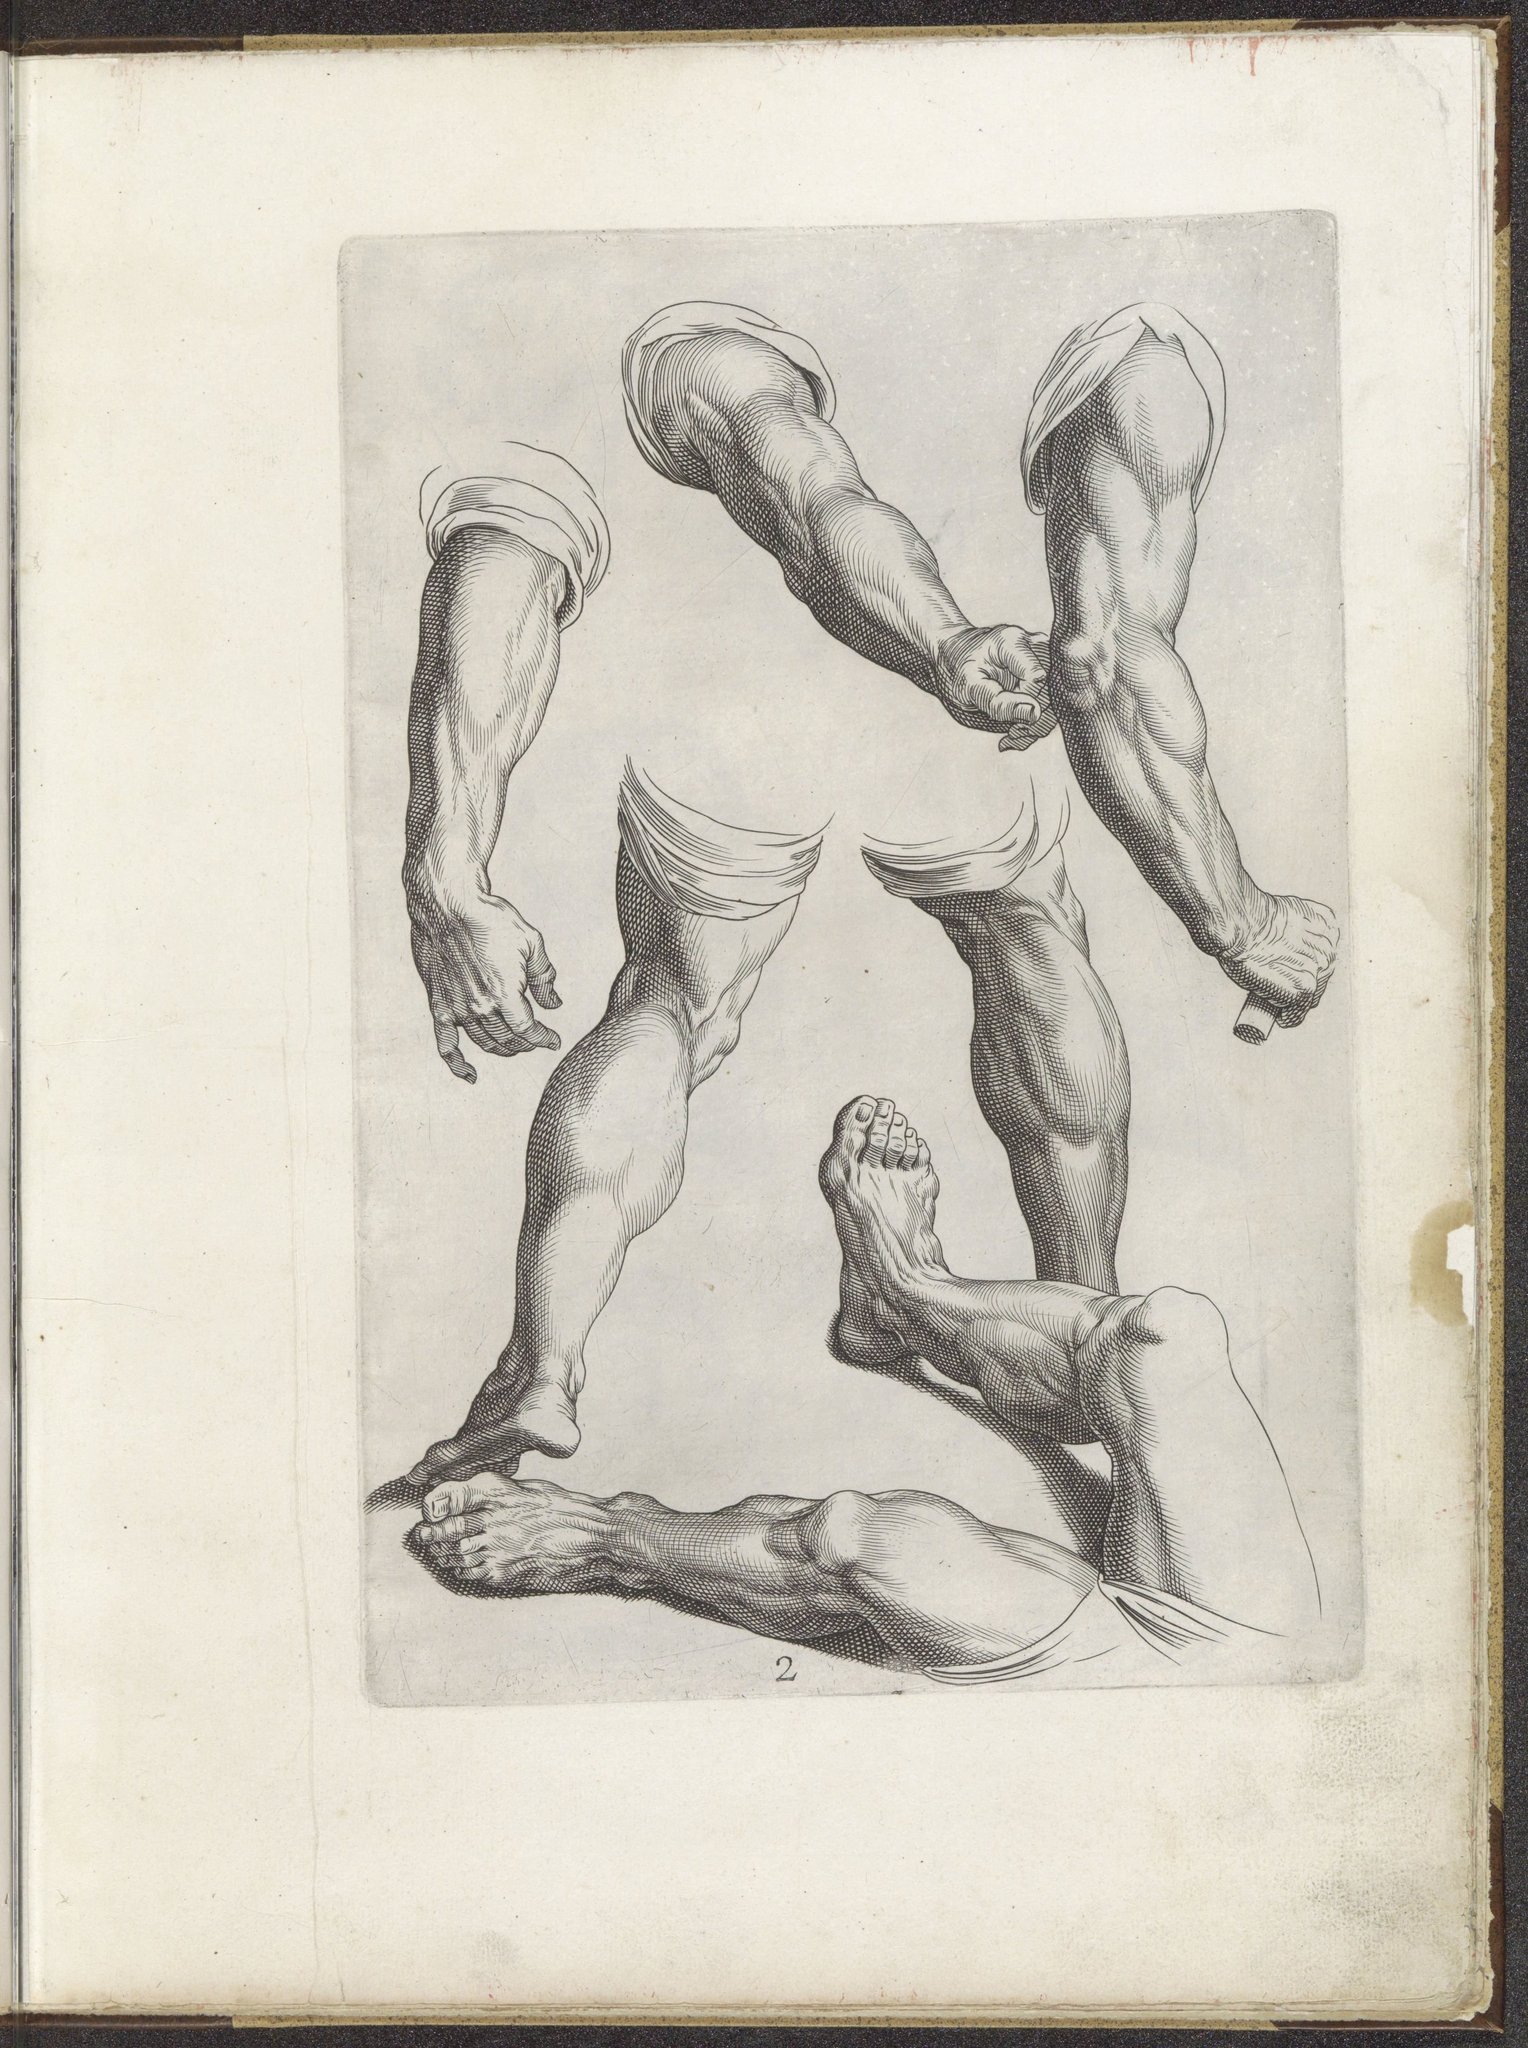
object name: print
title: Tekenvoorbeelden van armen en benen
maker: pieter de jode (i)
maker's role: draughtsman, print maker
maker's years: 1570-1634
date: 1629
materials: paper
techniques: engraving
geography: antwerp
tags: arms, postures of the legs, legs, postures and gestures of arms and hands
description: Tekenvoorbeelden. Boven: Drie armen in verschillende houdingen. Onder: vier benen. Deze prent maakt deel uit van een album.